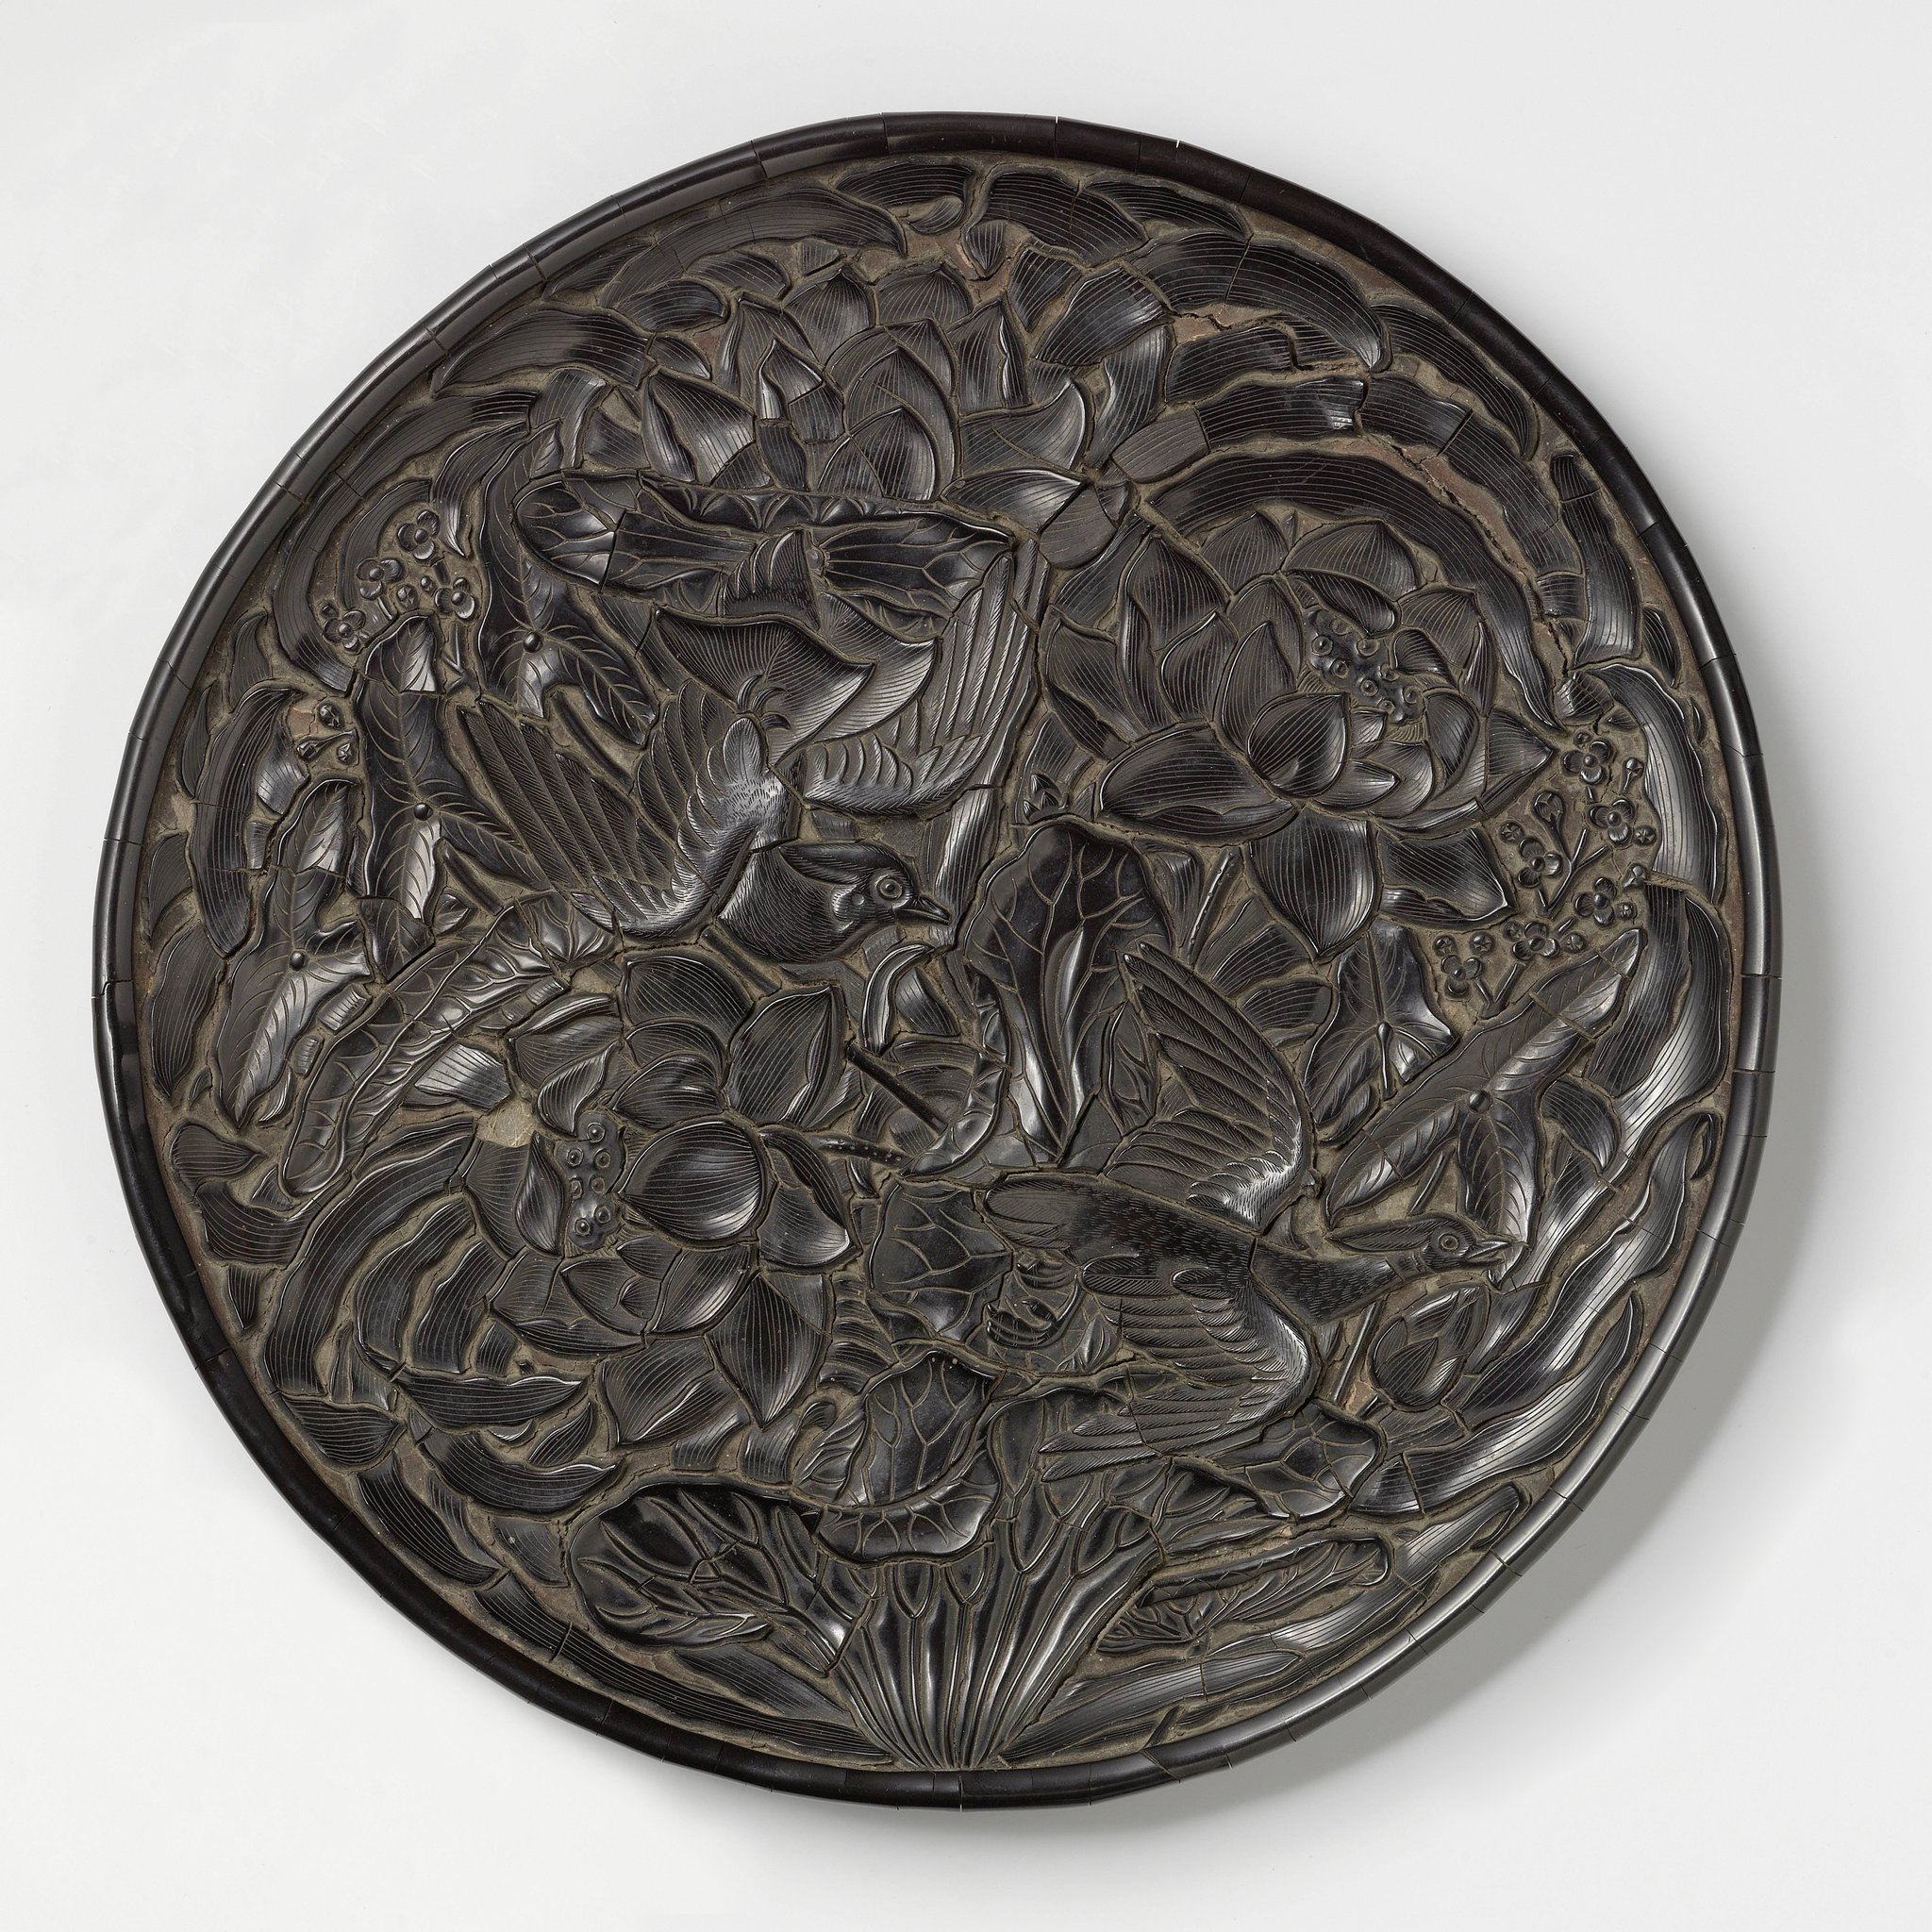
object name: dish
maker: zhang cheng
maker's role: laksnijder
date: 1300-1325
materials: lacquer, wood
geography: china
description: This lively carved dish features a pair of birds in flight against a background of lotus flowers and other water plants. The extraordinarily fine craftsmanship indicates that this dish was never meant for daily use. The production of lacquerware is an extremely time-consuming process that takes at least five years and sometimes involves the application of over two hundred layers of lacquer.